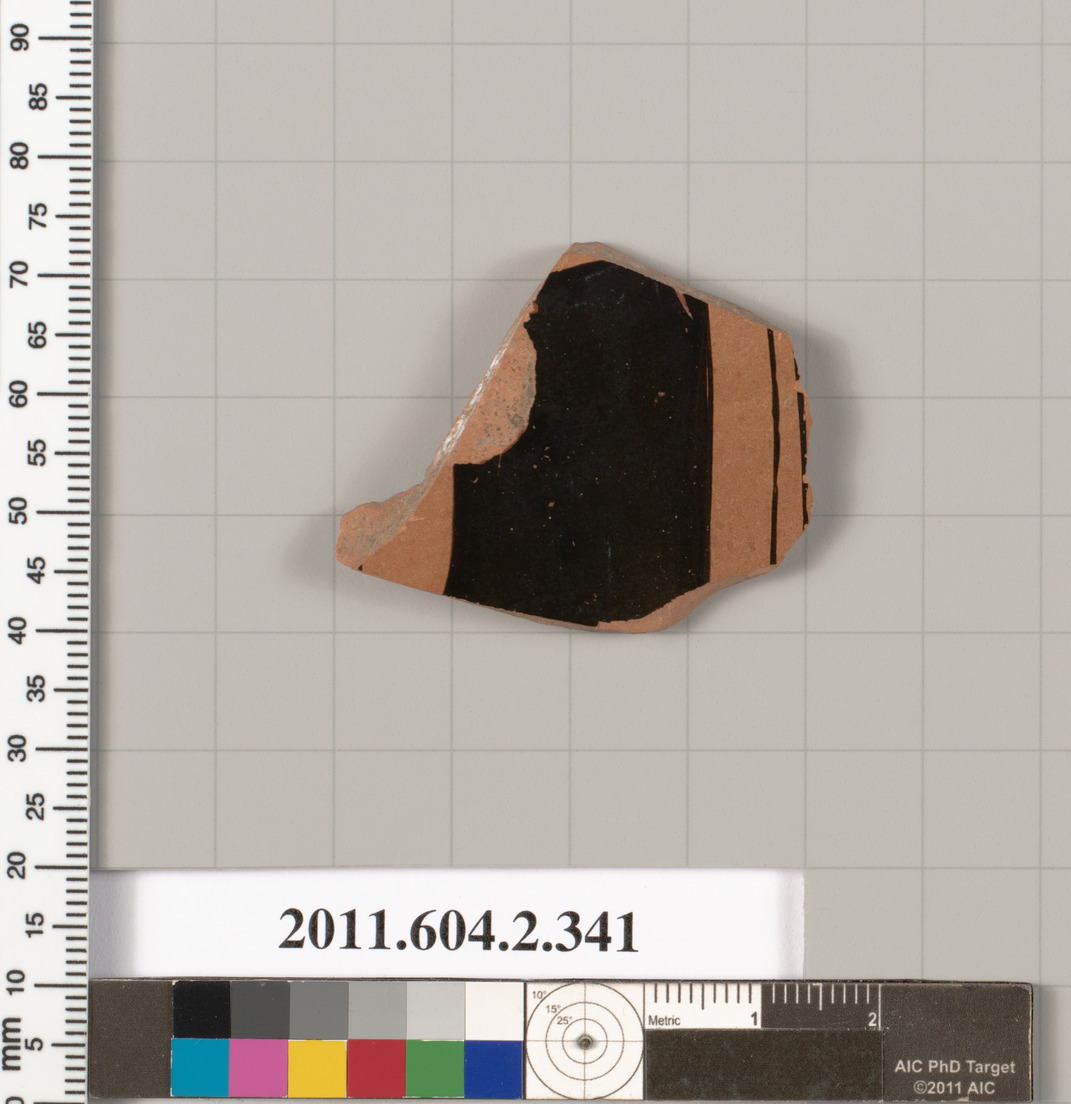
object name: column krater fragment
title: Terracotta fragment of a column-krater (bowl for mixing wine and water)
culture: greek, attic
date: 460-440 BCE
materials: terracotta